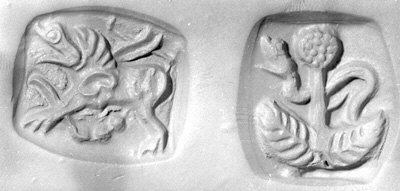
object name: stamp seal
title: Double-sided stamp seal: snake behind tree; winged dragon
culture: bactria-margiana archaeological complex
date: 2333-1668 BCE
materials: iron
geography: bactria-margiana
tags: dragons,snakes,leaves